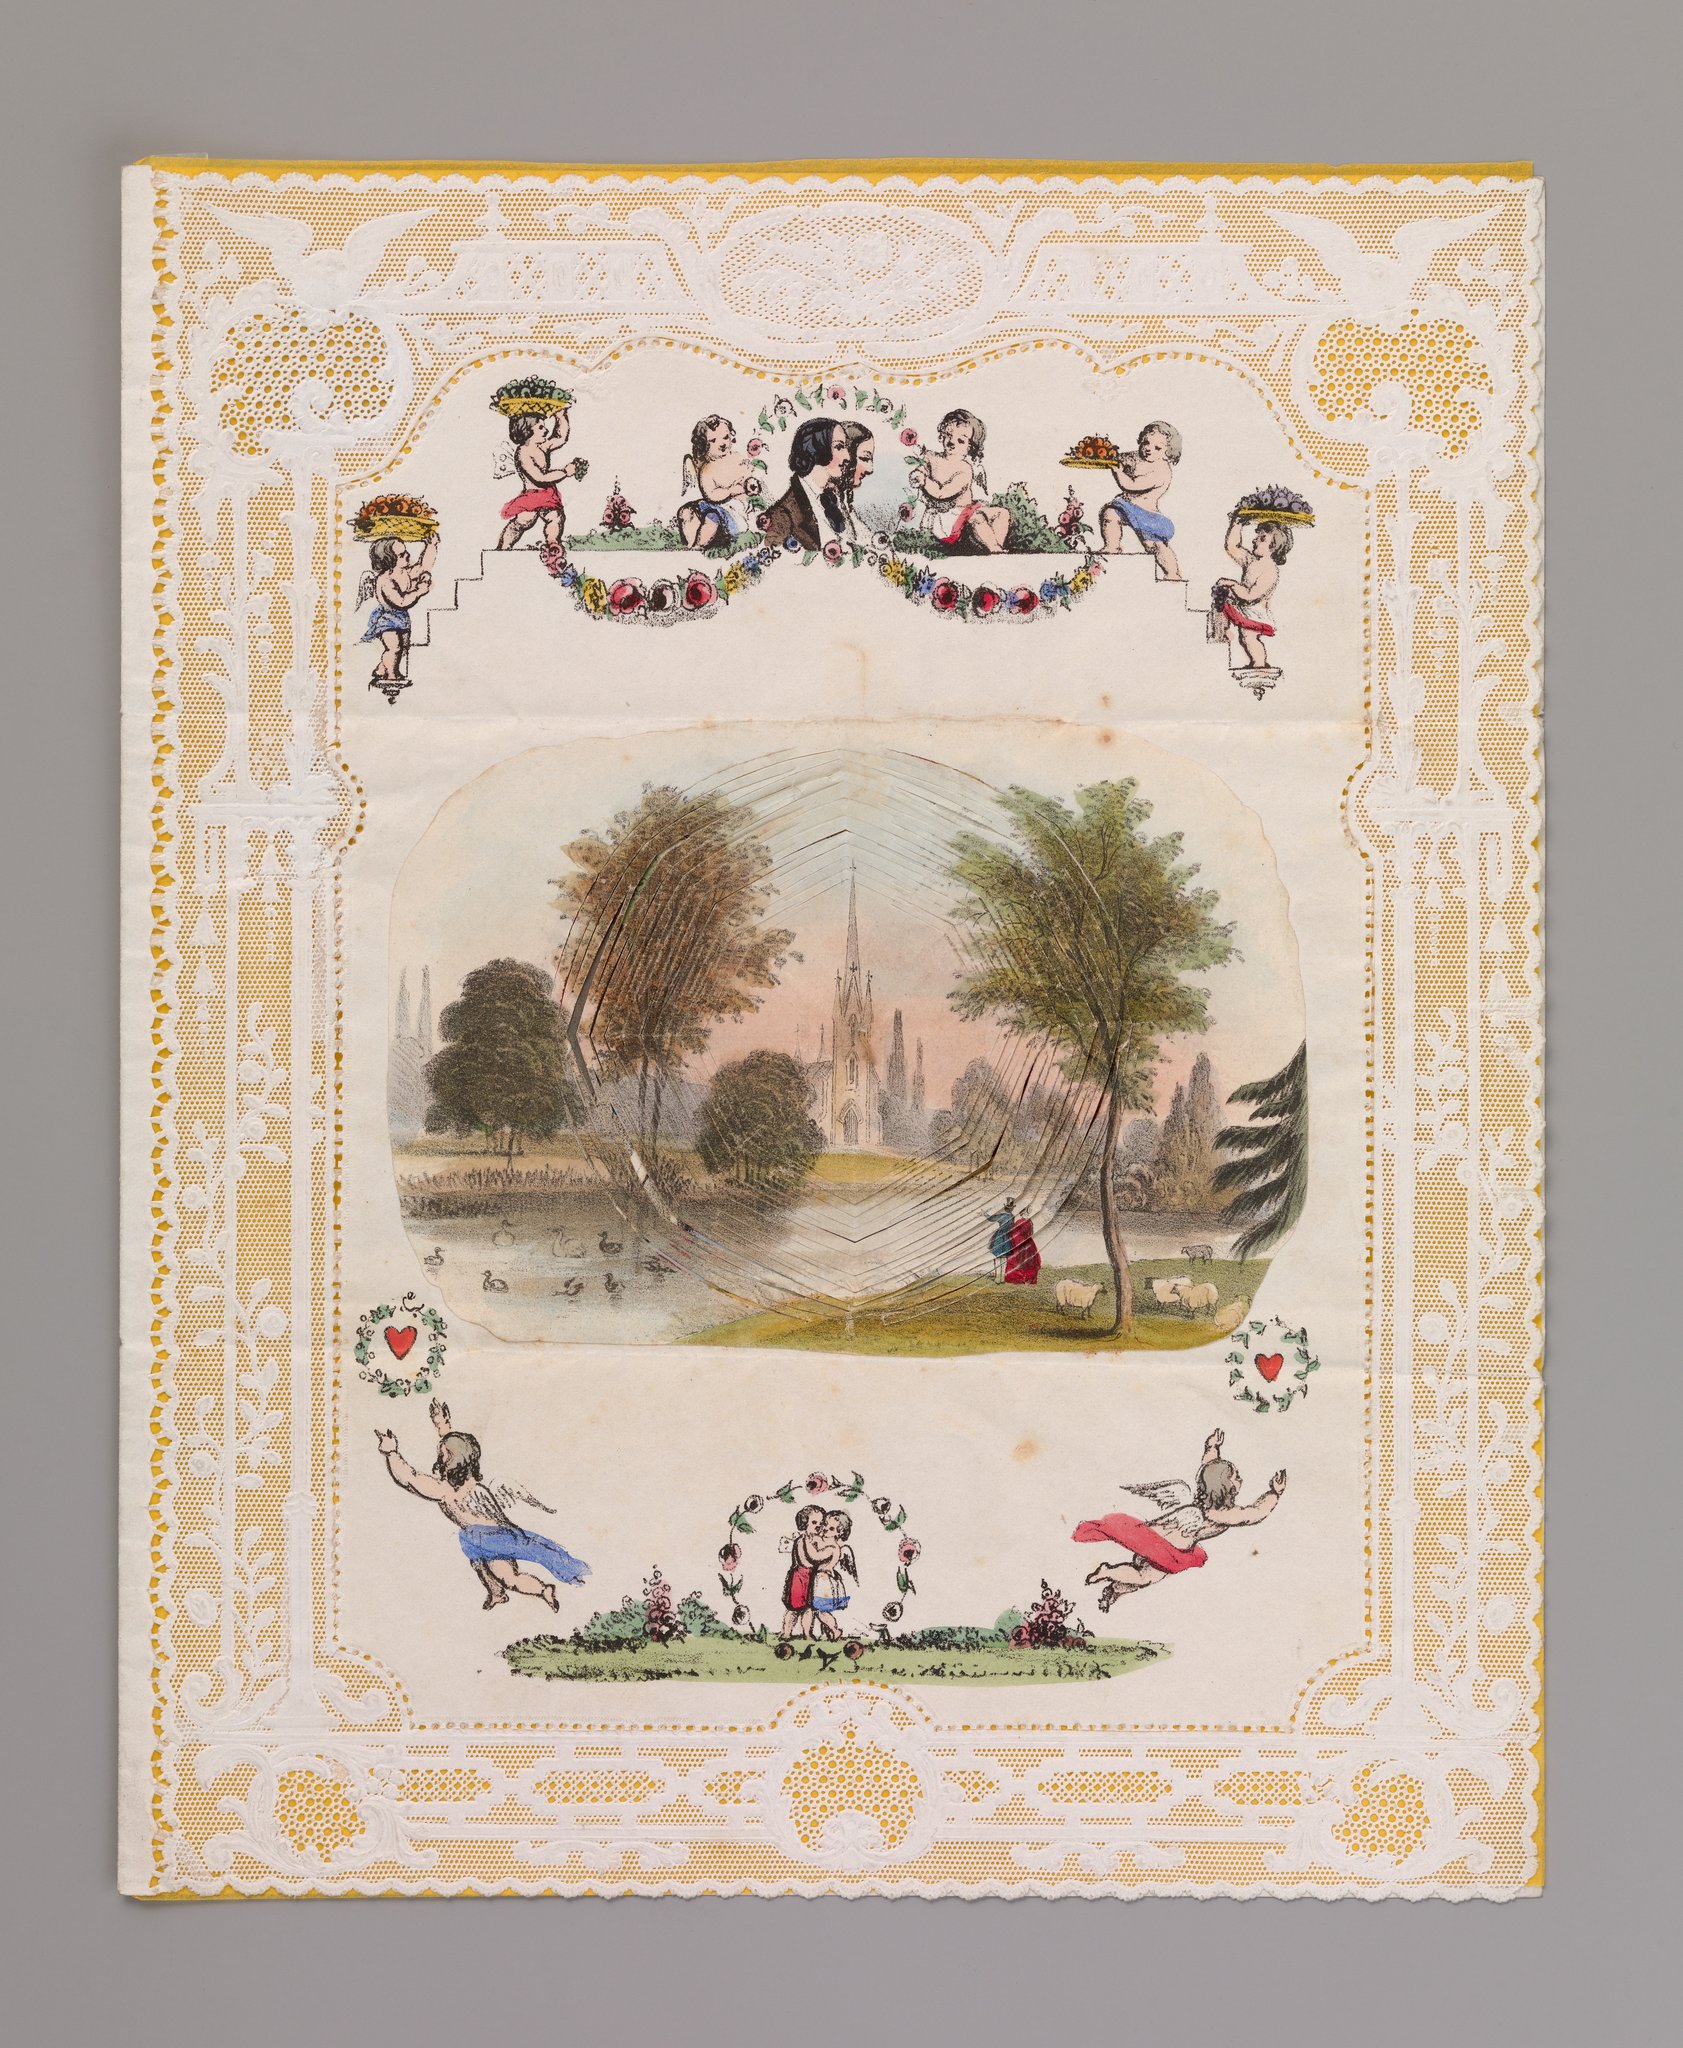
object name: valentine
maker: Anonymous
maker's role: artist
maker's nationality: british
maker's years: 1800-1899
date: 1830-1850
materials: paper, watercolor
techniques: embossing, lithograph, open work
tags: children,cupid,landscapes